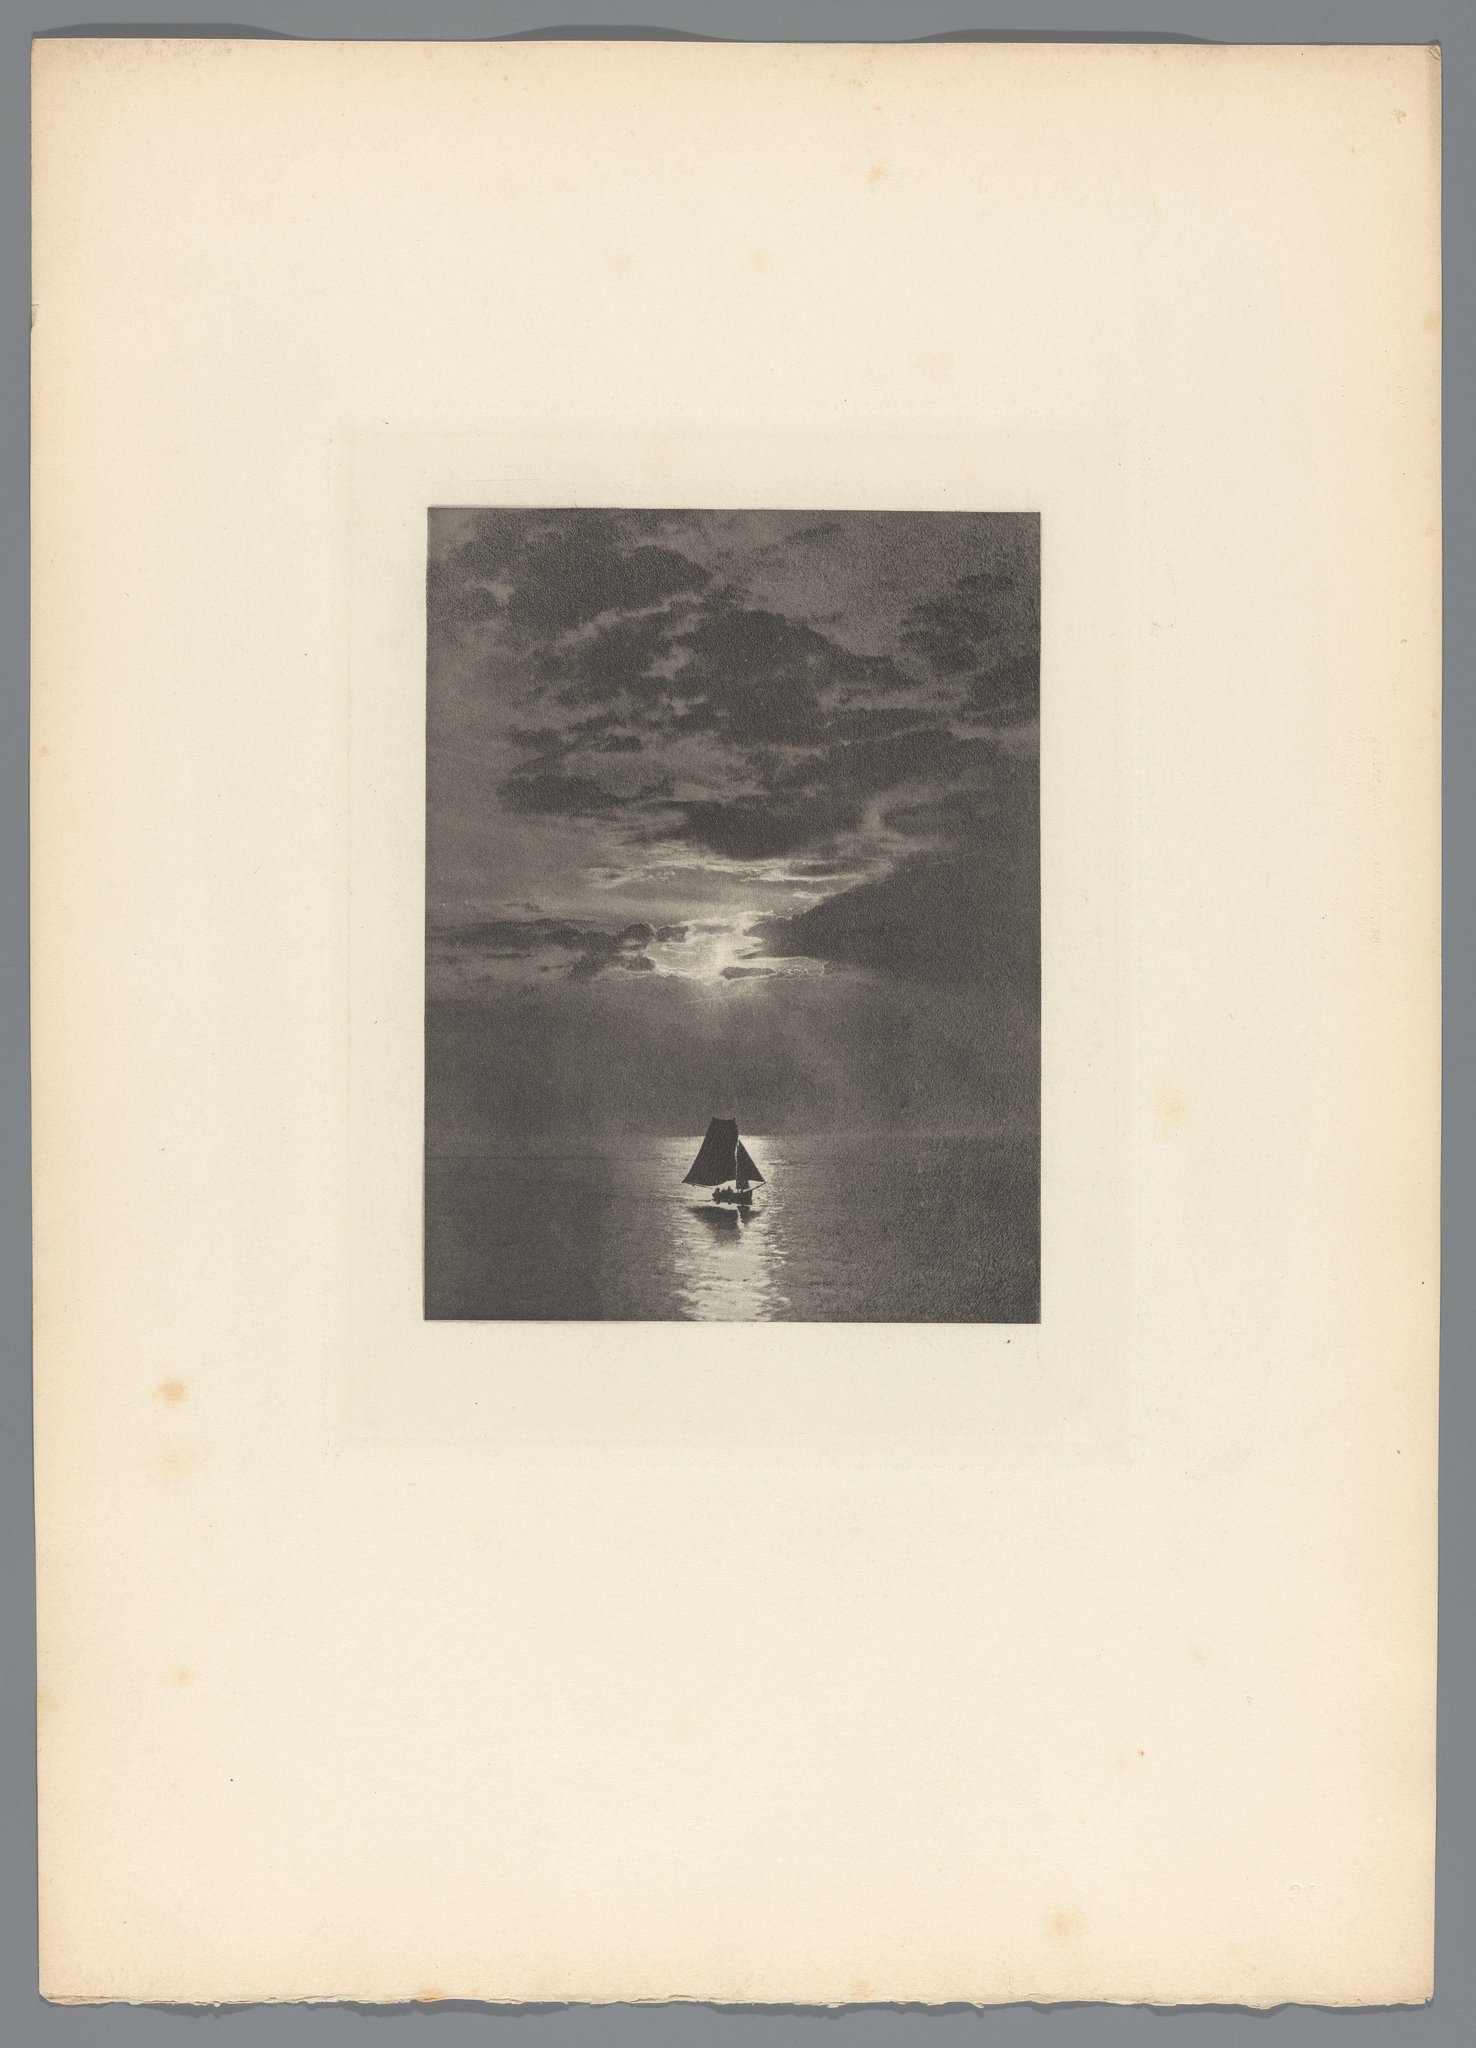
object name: photomechanical print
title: Clair de lune sur la mer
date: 1891-1896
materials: paper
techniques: photoaquatint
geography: paris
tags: sailing-ship, sailing-boat, moonlight, sea (seascape)